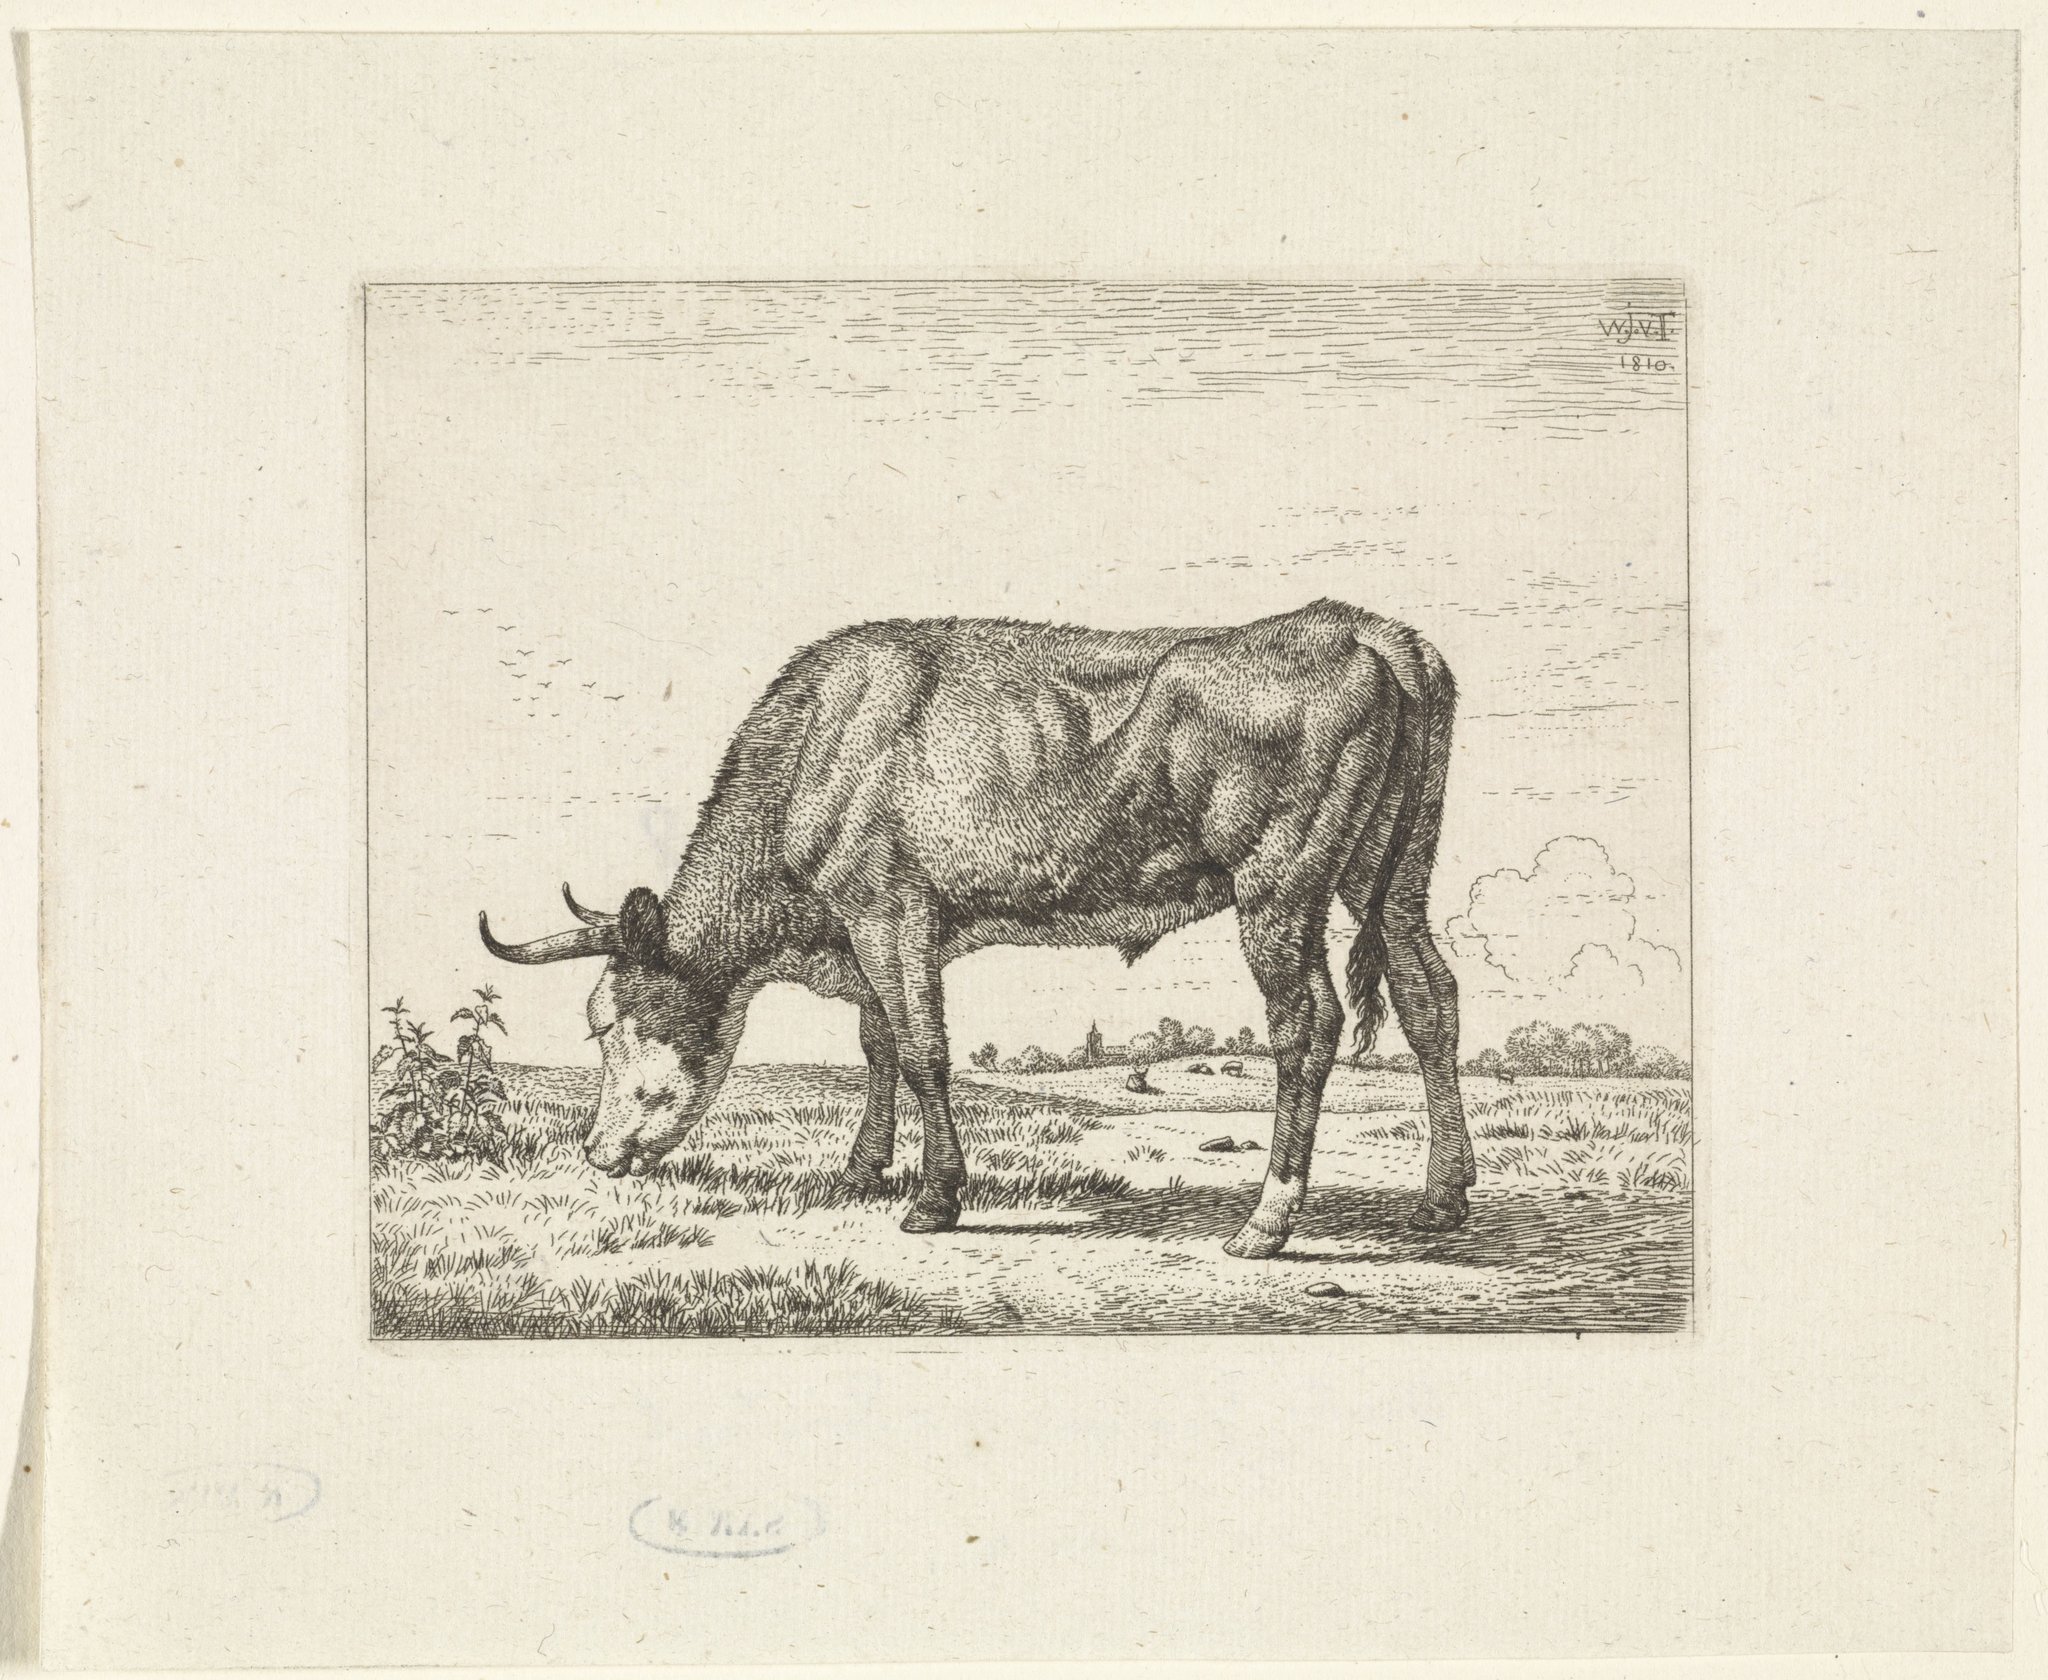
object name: print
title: Grazende koe naar links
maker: wouter johannes van troostwijk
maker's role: draughtsman, painter, print maker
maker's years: 1782-1810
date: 1810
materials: paper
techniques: etching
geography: amsterdam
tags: cow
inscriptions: collector's mark: Lugt 2760, collector's mark: Lugt 2228